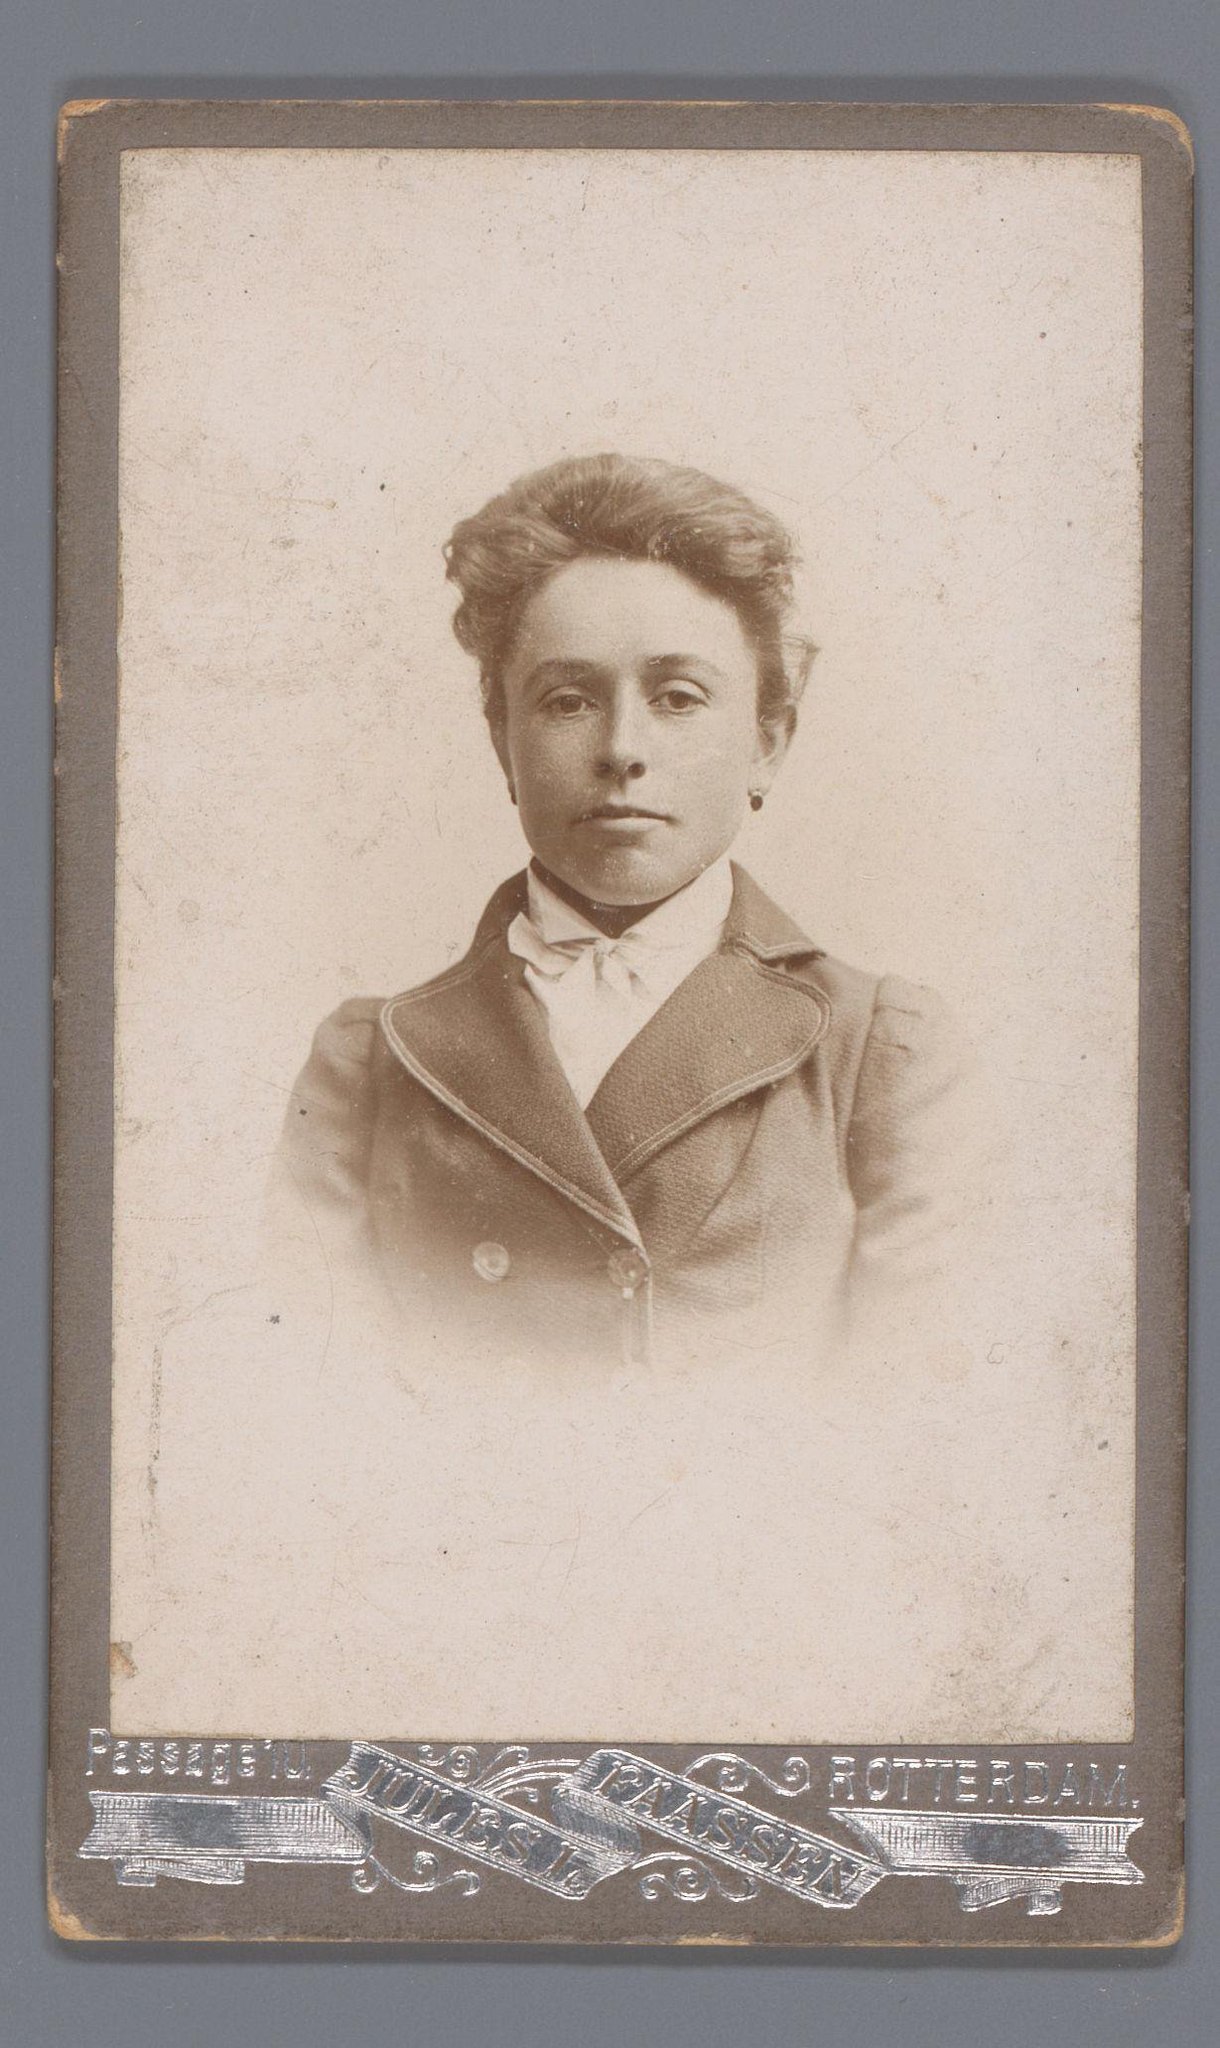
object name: photograph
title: Portret van een onbekende vrouw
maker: jules louis faassen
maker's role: fotograaf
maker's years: 1845-1925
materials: paper, cardboard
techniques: collodion silver print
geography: rotterdam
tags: adult woman, anonymous historical person portrayed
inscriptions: address: ‘Passage 10./ Rotterdam’